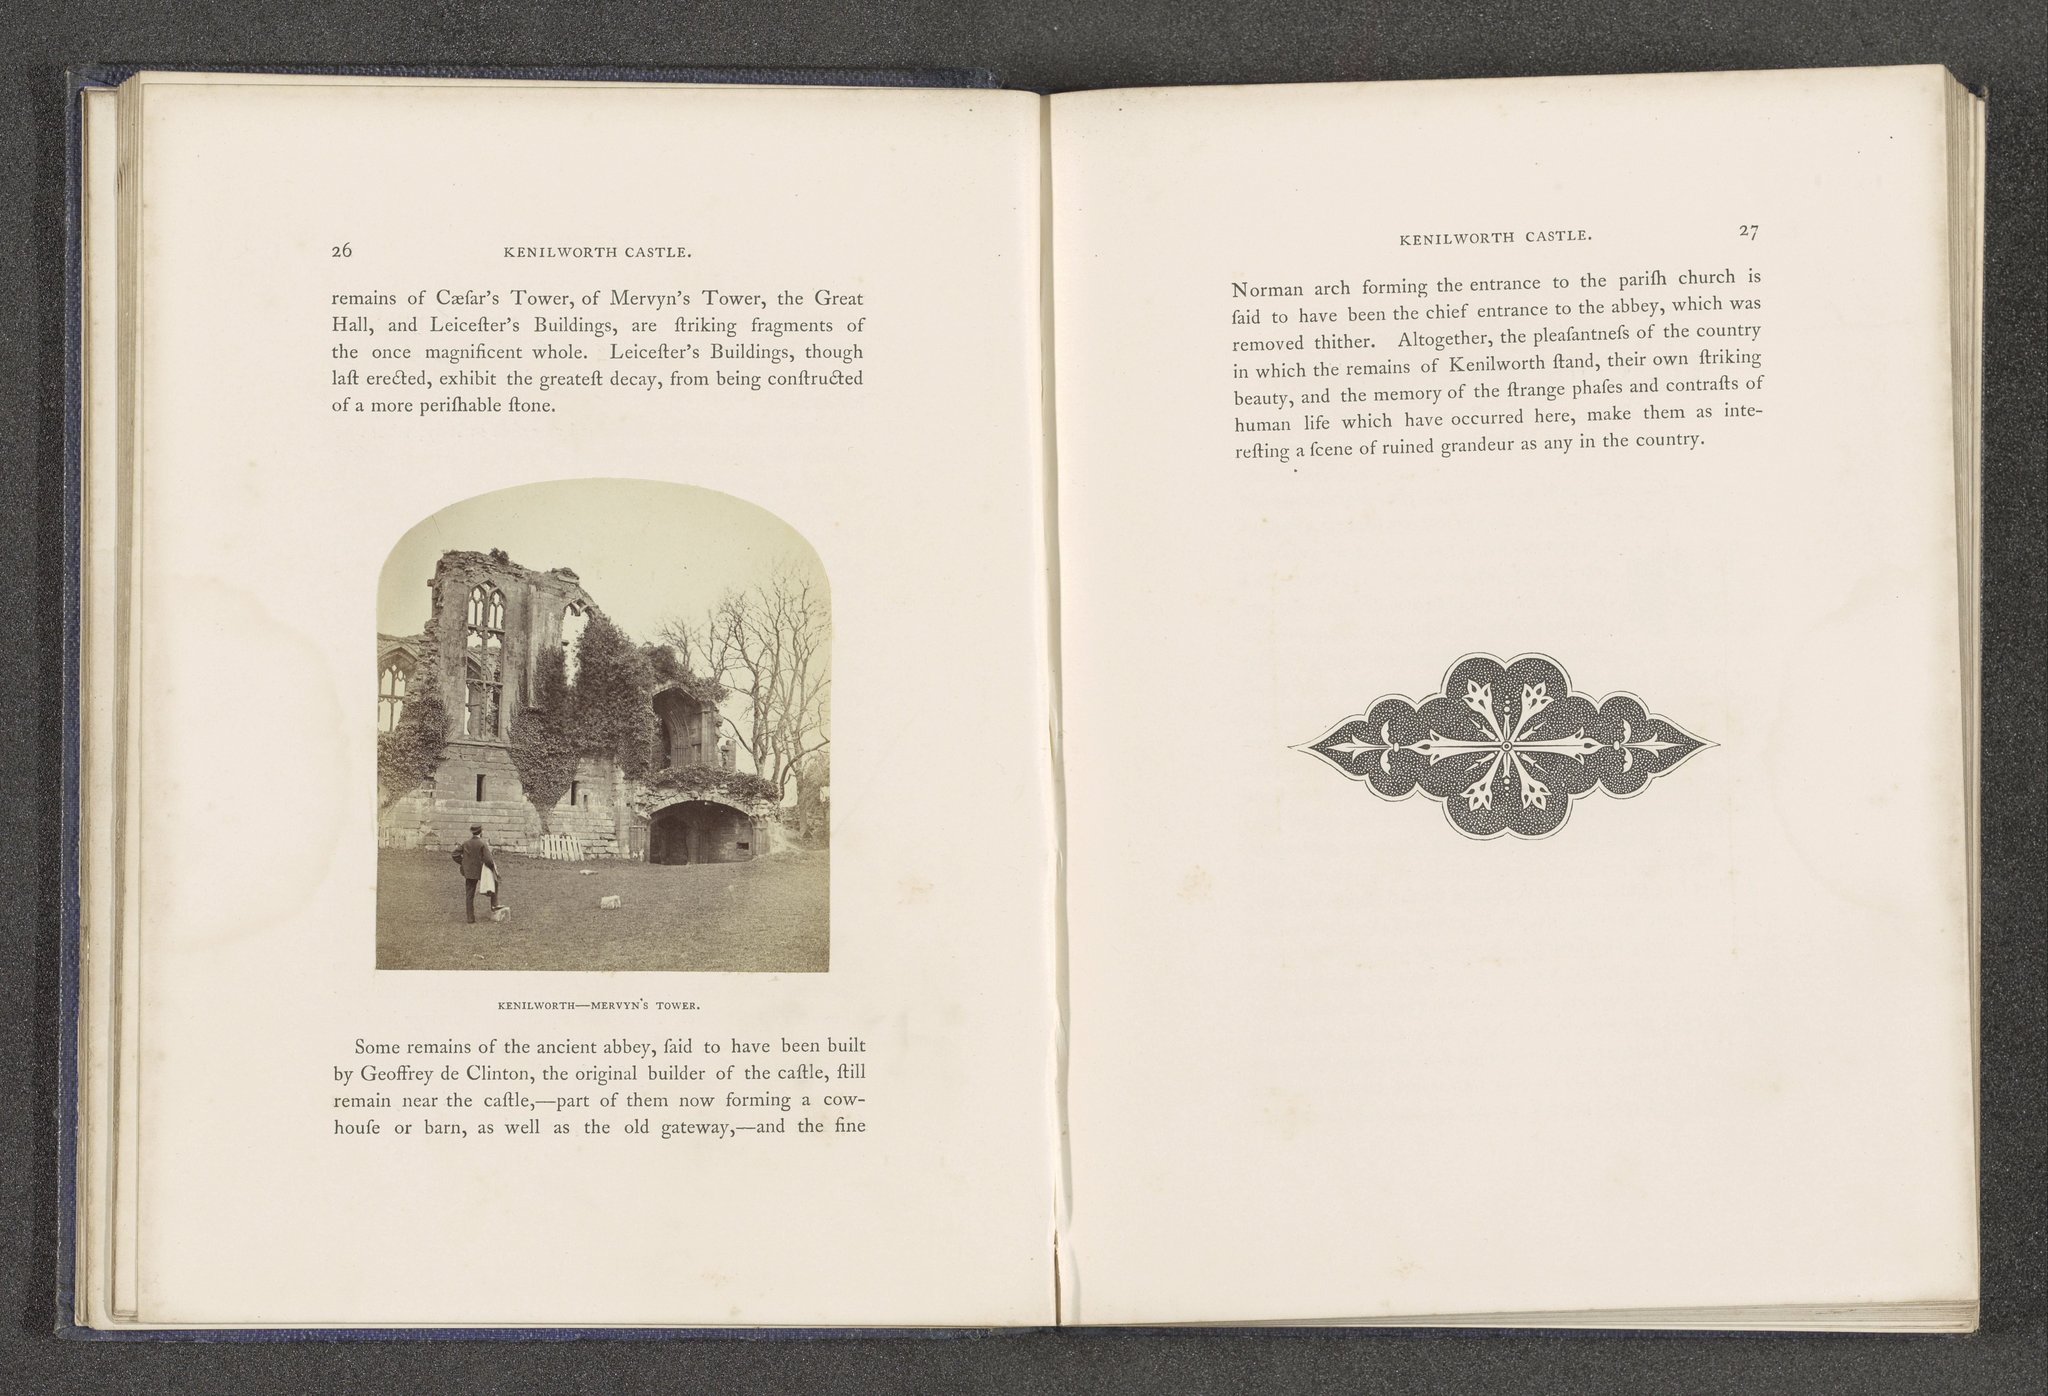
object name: page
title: Ruïne van Mervyn's Tower van het kasteel van Kenilworth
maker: stephen thompson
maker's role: fotograaf, schrijver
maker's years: 1831-1893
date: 1854-1864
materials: photographic support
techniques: albumen print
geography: kenilworth castle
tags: tower, clock tower ~ monumental adornment, ruin of a dwelling, house, castle, etc.